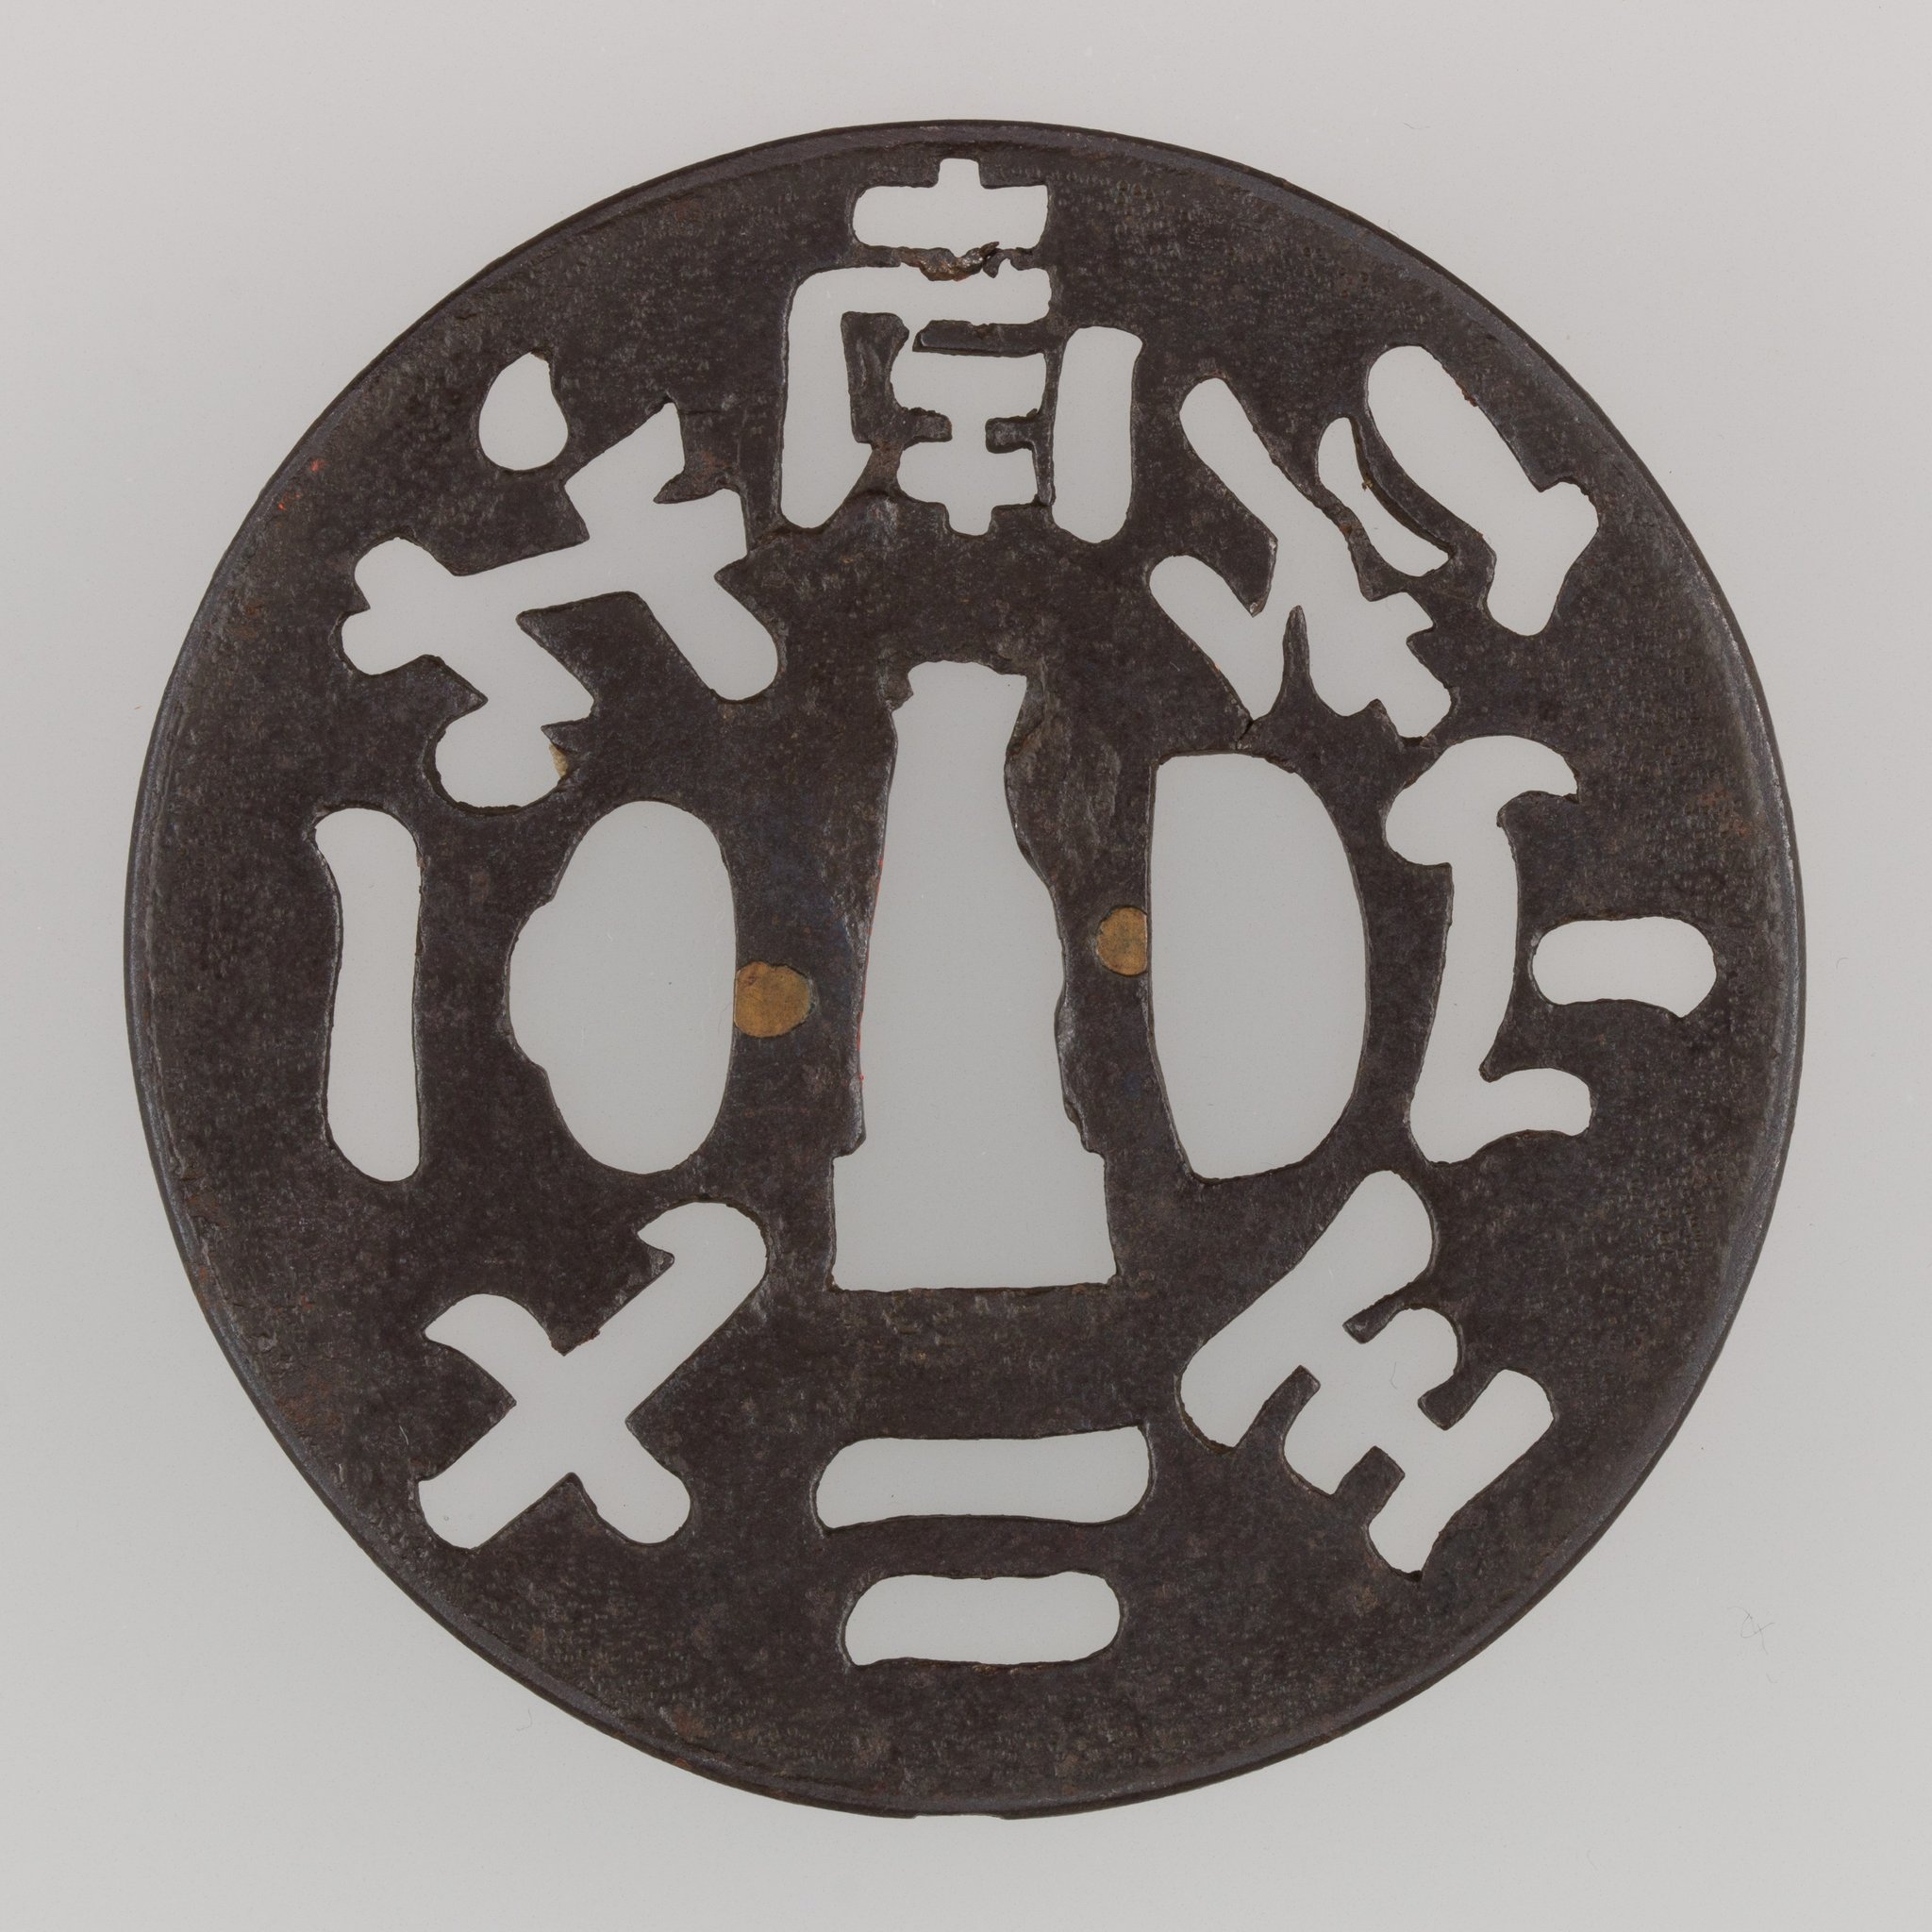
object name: sword guard tsuba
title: Sword Guard (Tsuba)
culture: japanese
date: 1601-1700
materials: copper, iron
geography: japan